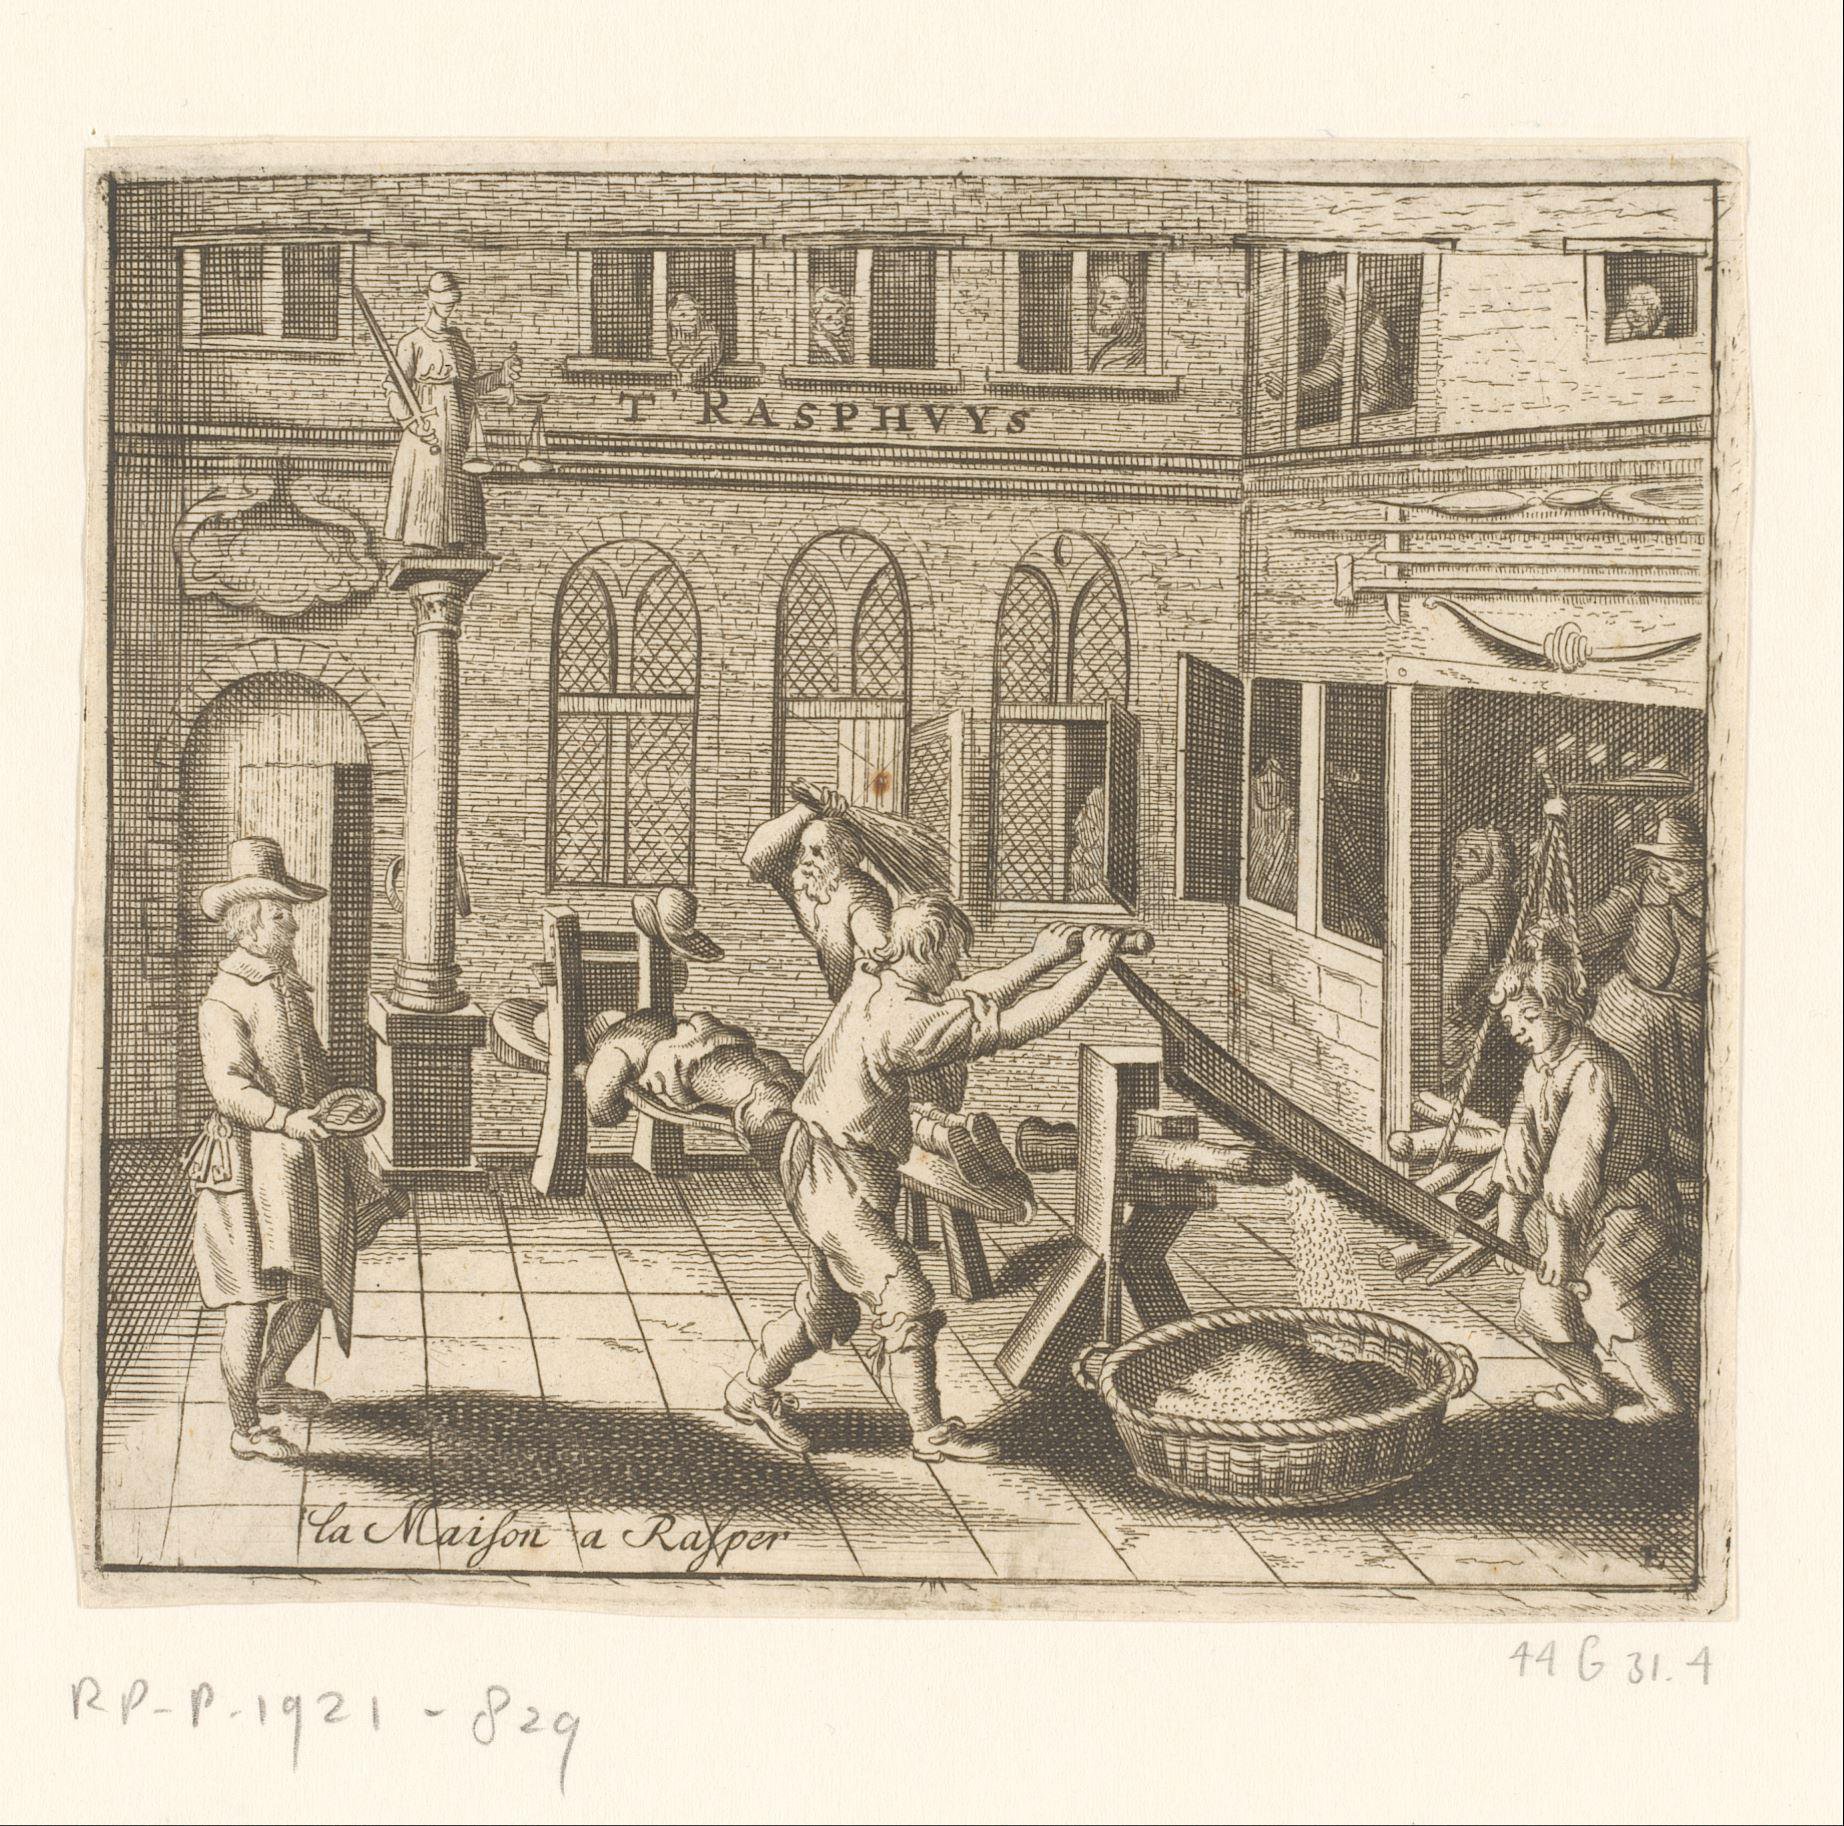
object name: print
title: Gezicht op de binnenplaats van het Rasphuis te Amsterdam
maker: Anonymous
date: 1665-1670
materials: paper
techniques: engraving, etching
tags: (prisoners) in the prison yard, justitia (justice) as roman personification, workhouse, penal camp, penitentiary, chain gang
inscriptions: collector's mark: Lugt 2228, collector's mark: Lugt 2233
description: Vermoedelijk een kopie naar de prent in: Domselaer, Tobias, en Isaac Commelin. Beschryvinge van Amsterdam: haar eerste oorspronk uyt den huyze der heeren van Aemstel en Aemstellant (…). 6 dln. Amsterdam: Marcus Willemsz van Doornick, 1665. Zie bijvoorbeeld RP-P-1921-827.